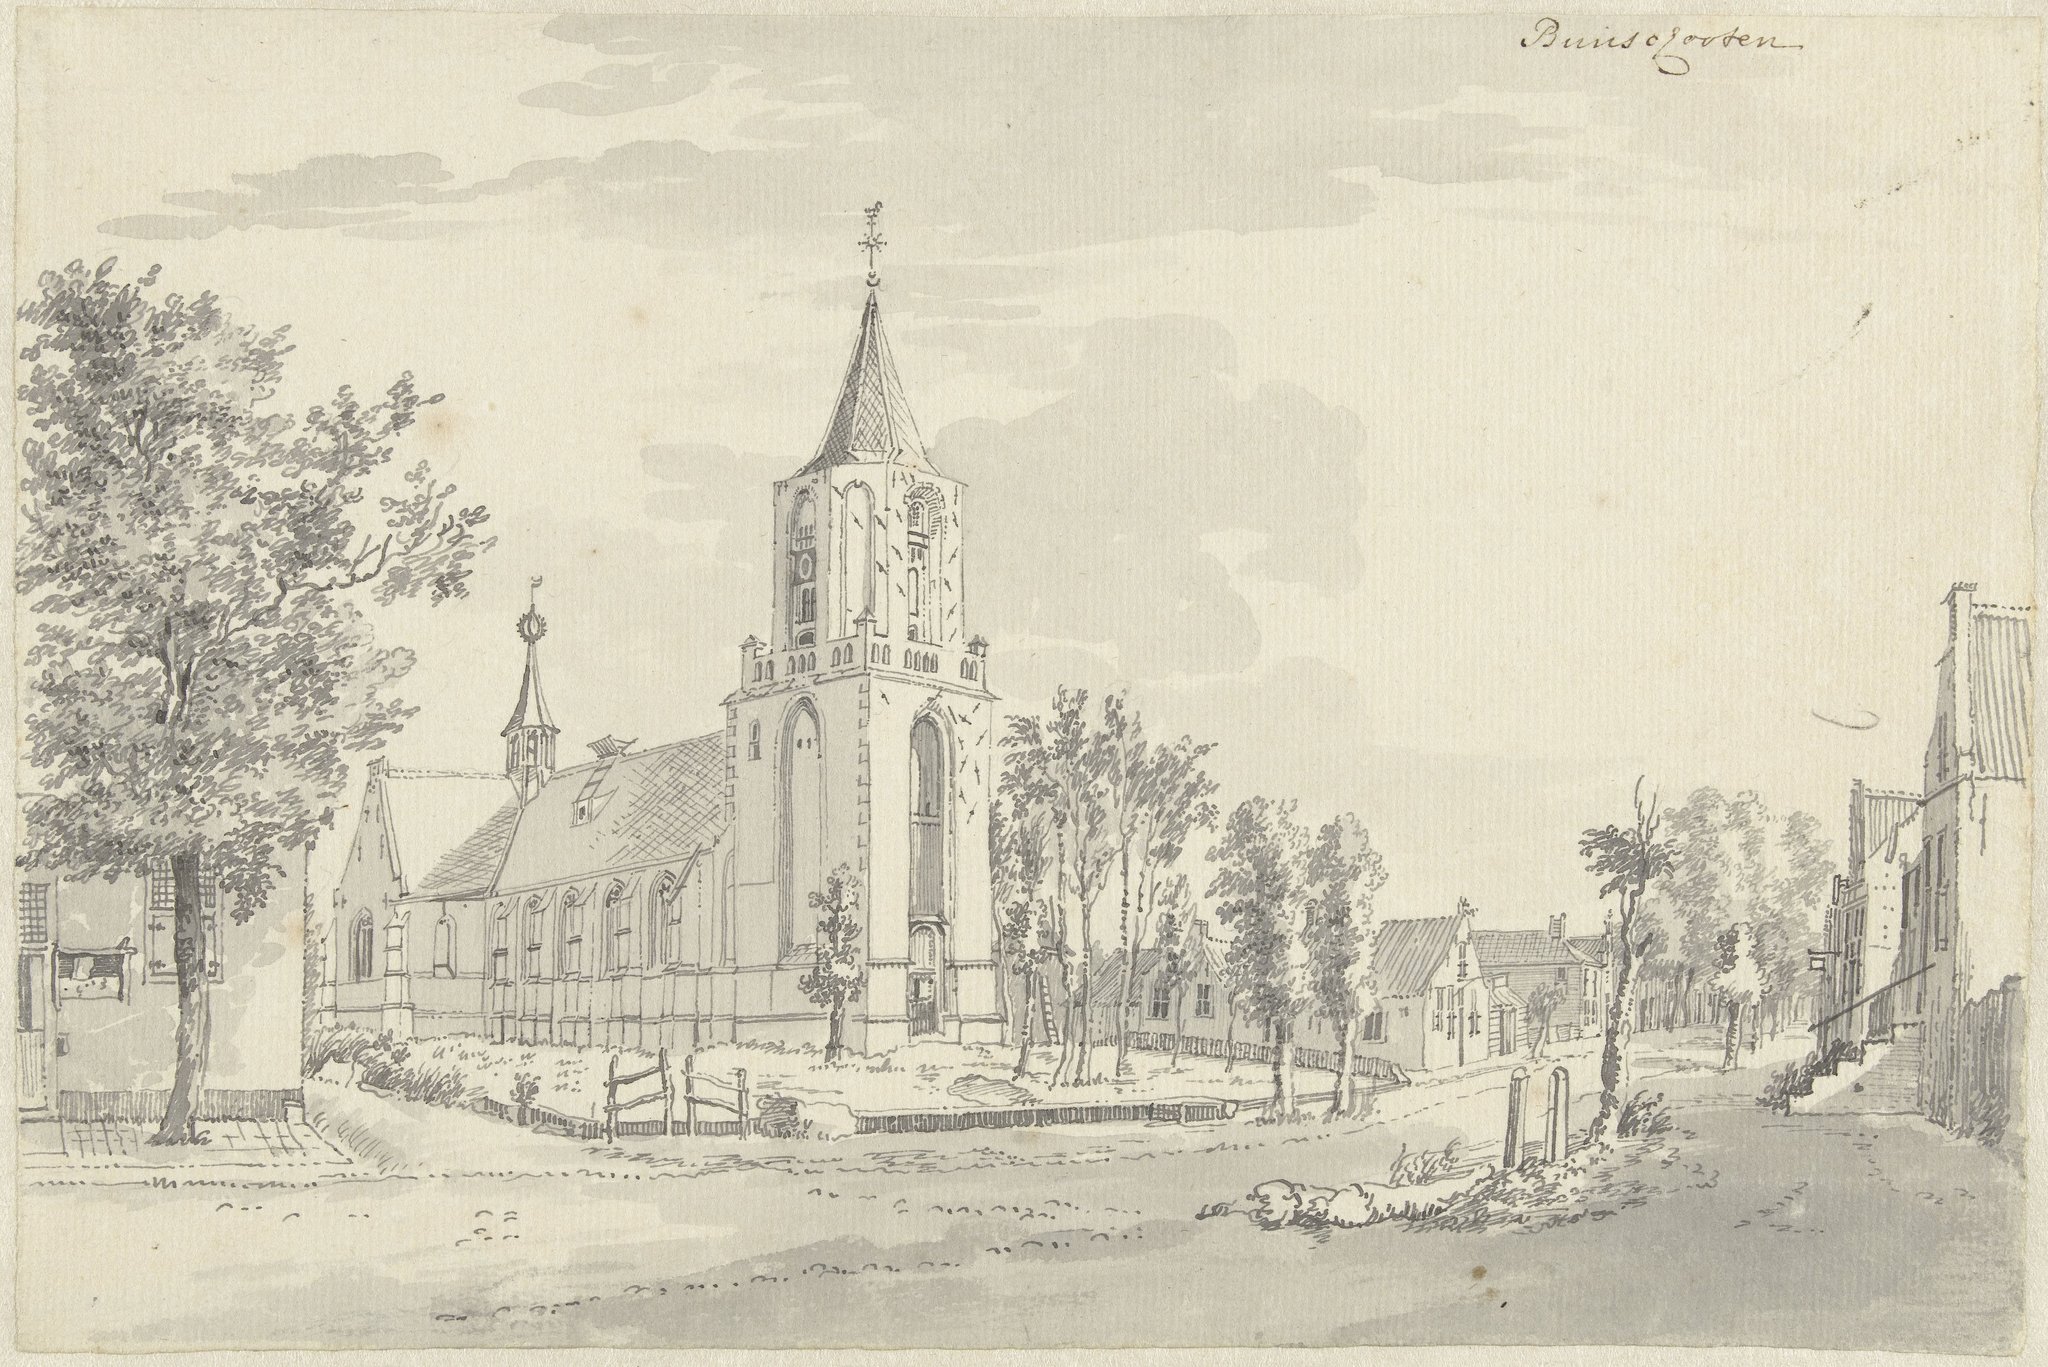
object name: drawing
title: Gezicht te Bunschoten, met de kerk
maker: jan de beijer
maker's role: draughtsman, print maker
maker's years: 1703-1780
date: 1713-1780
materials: ink, paper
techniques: brush, pen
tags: church (exterior), public road